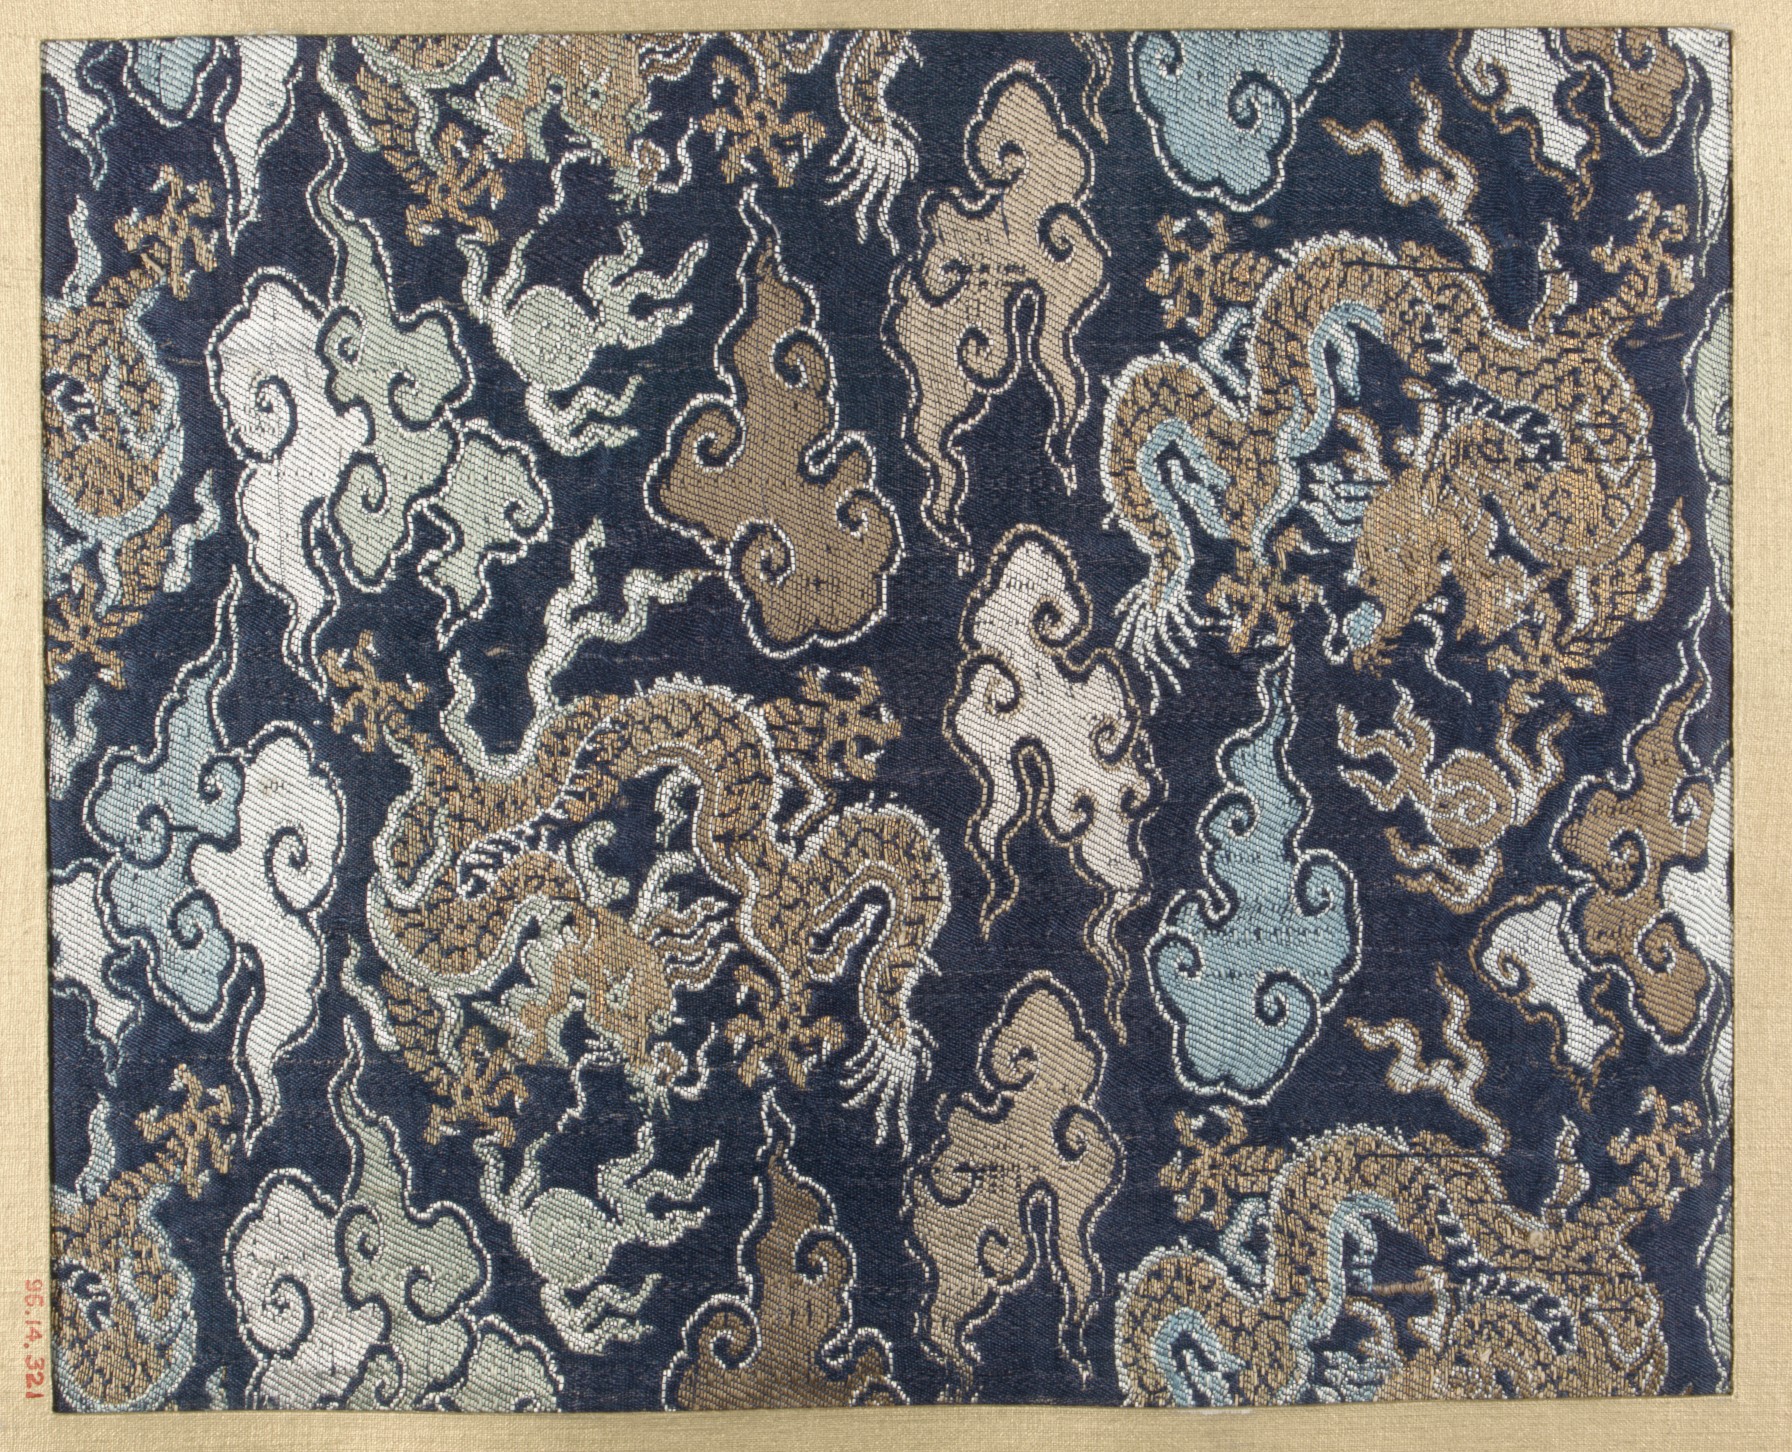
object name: piece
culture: chinese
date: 1701-1900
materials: silk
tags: dragons,clouds